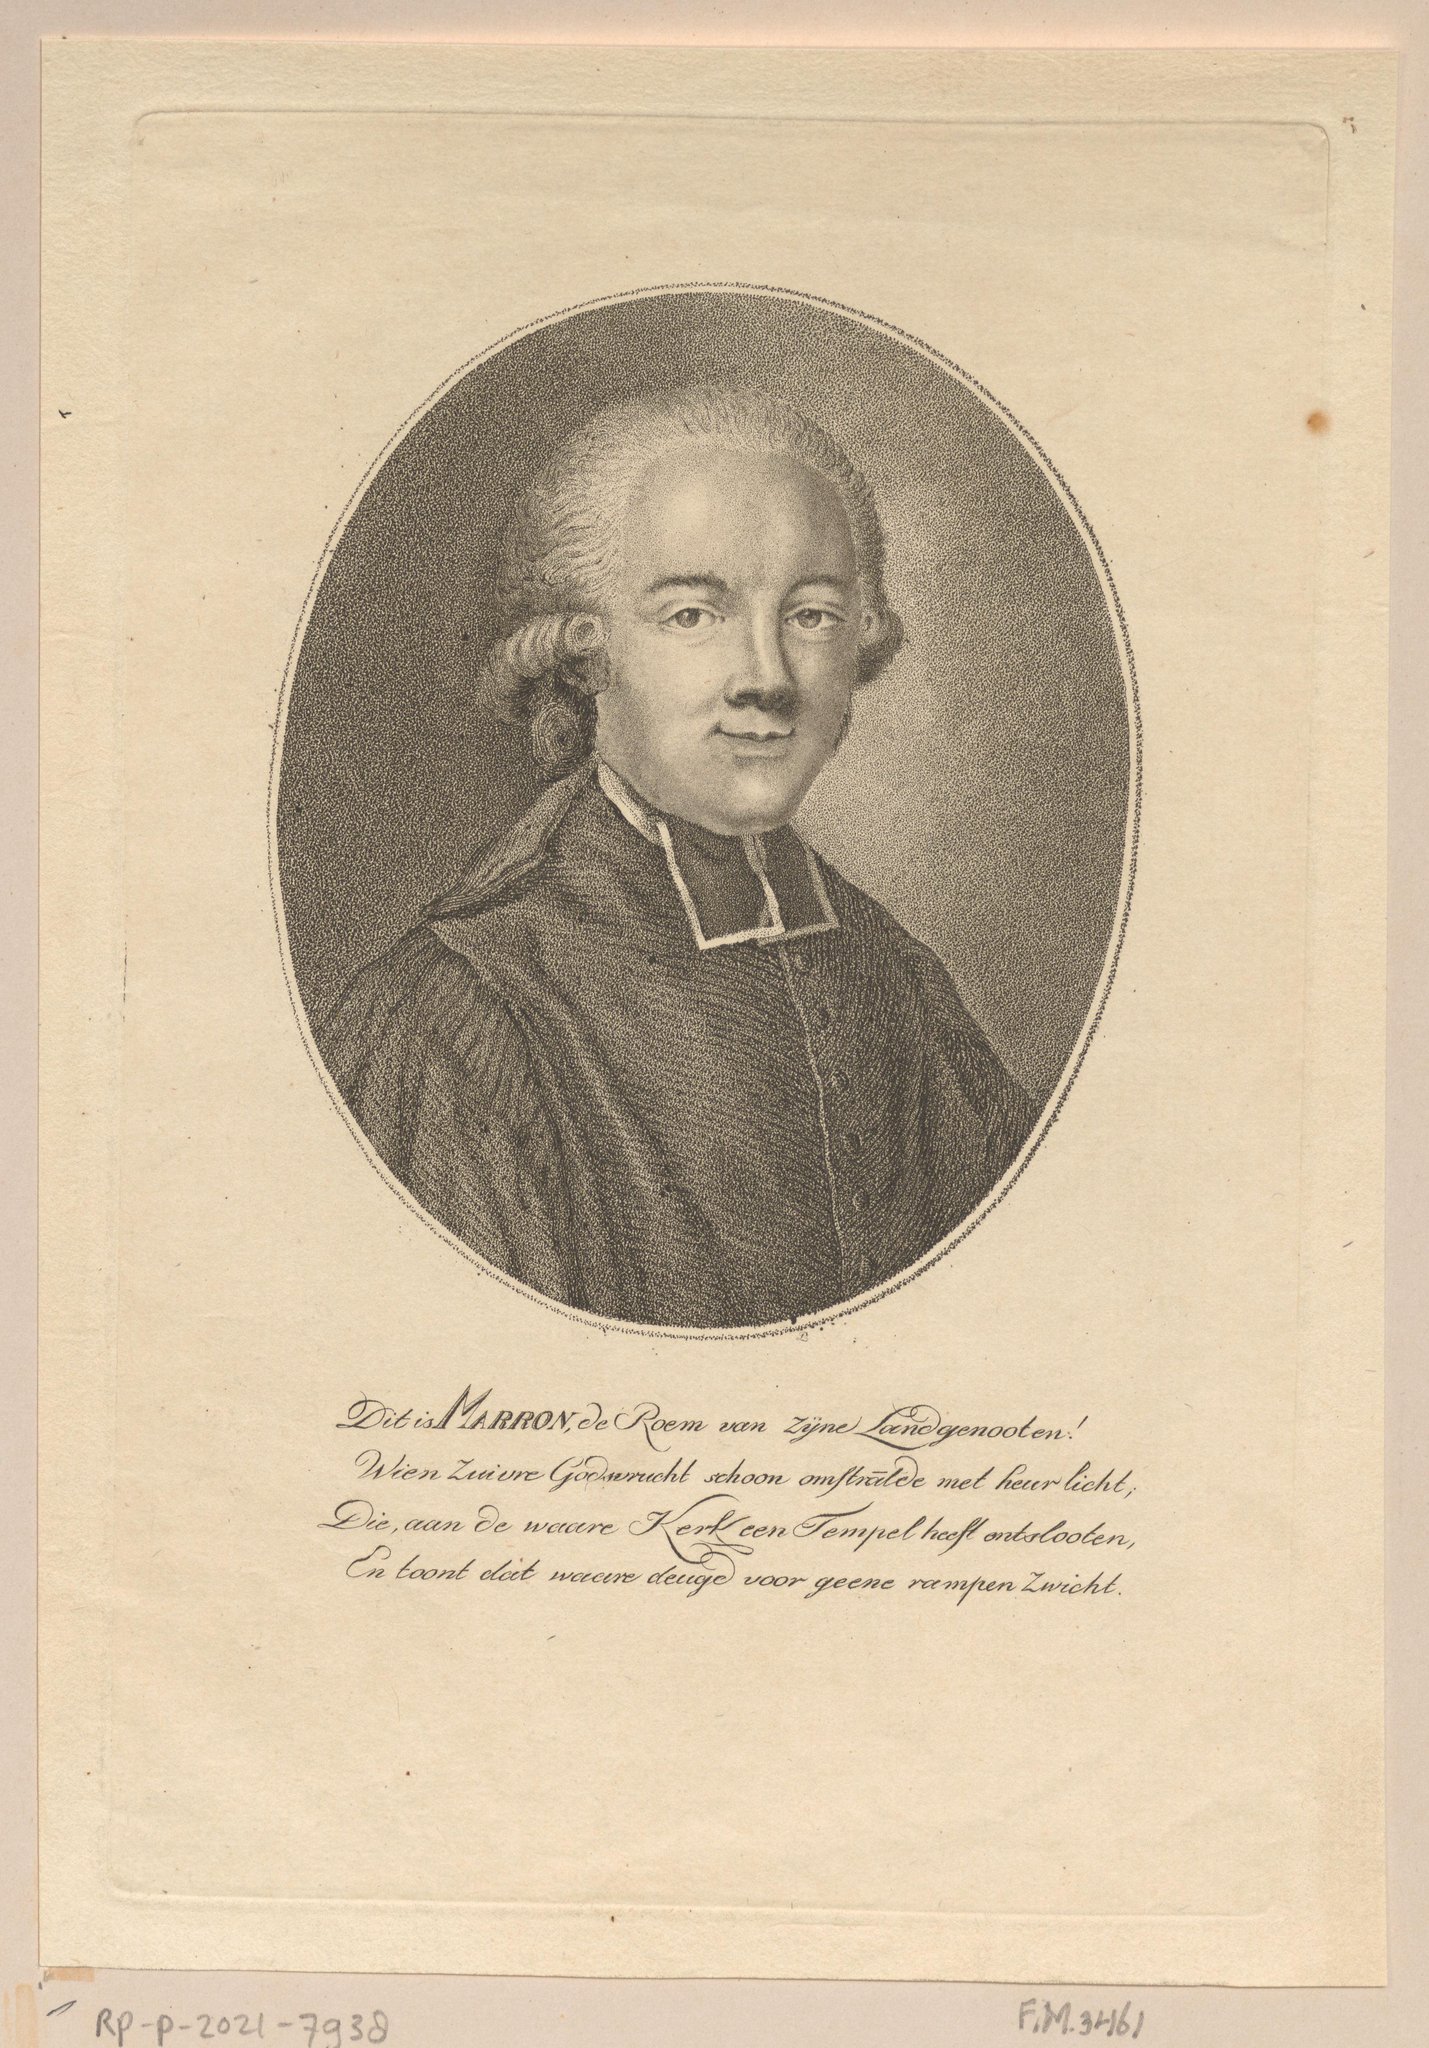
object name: print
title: Portret van Paul Henri Marron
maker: Anonymous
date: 1790-1810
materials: paper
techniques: engraving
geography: netherlands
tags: paris, paul henri marron, historical persons, portrait of a writer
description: Met vierregelig lofdicht in het Nederlands.